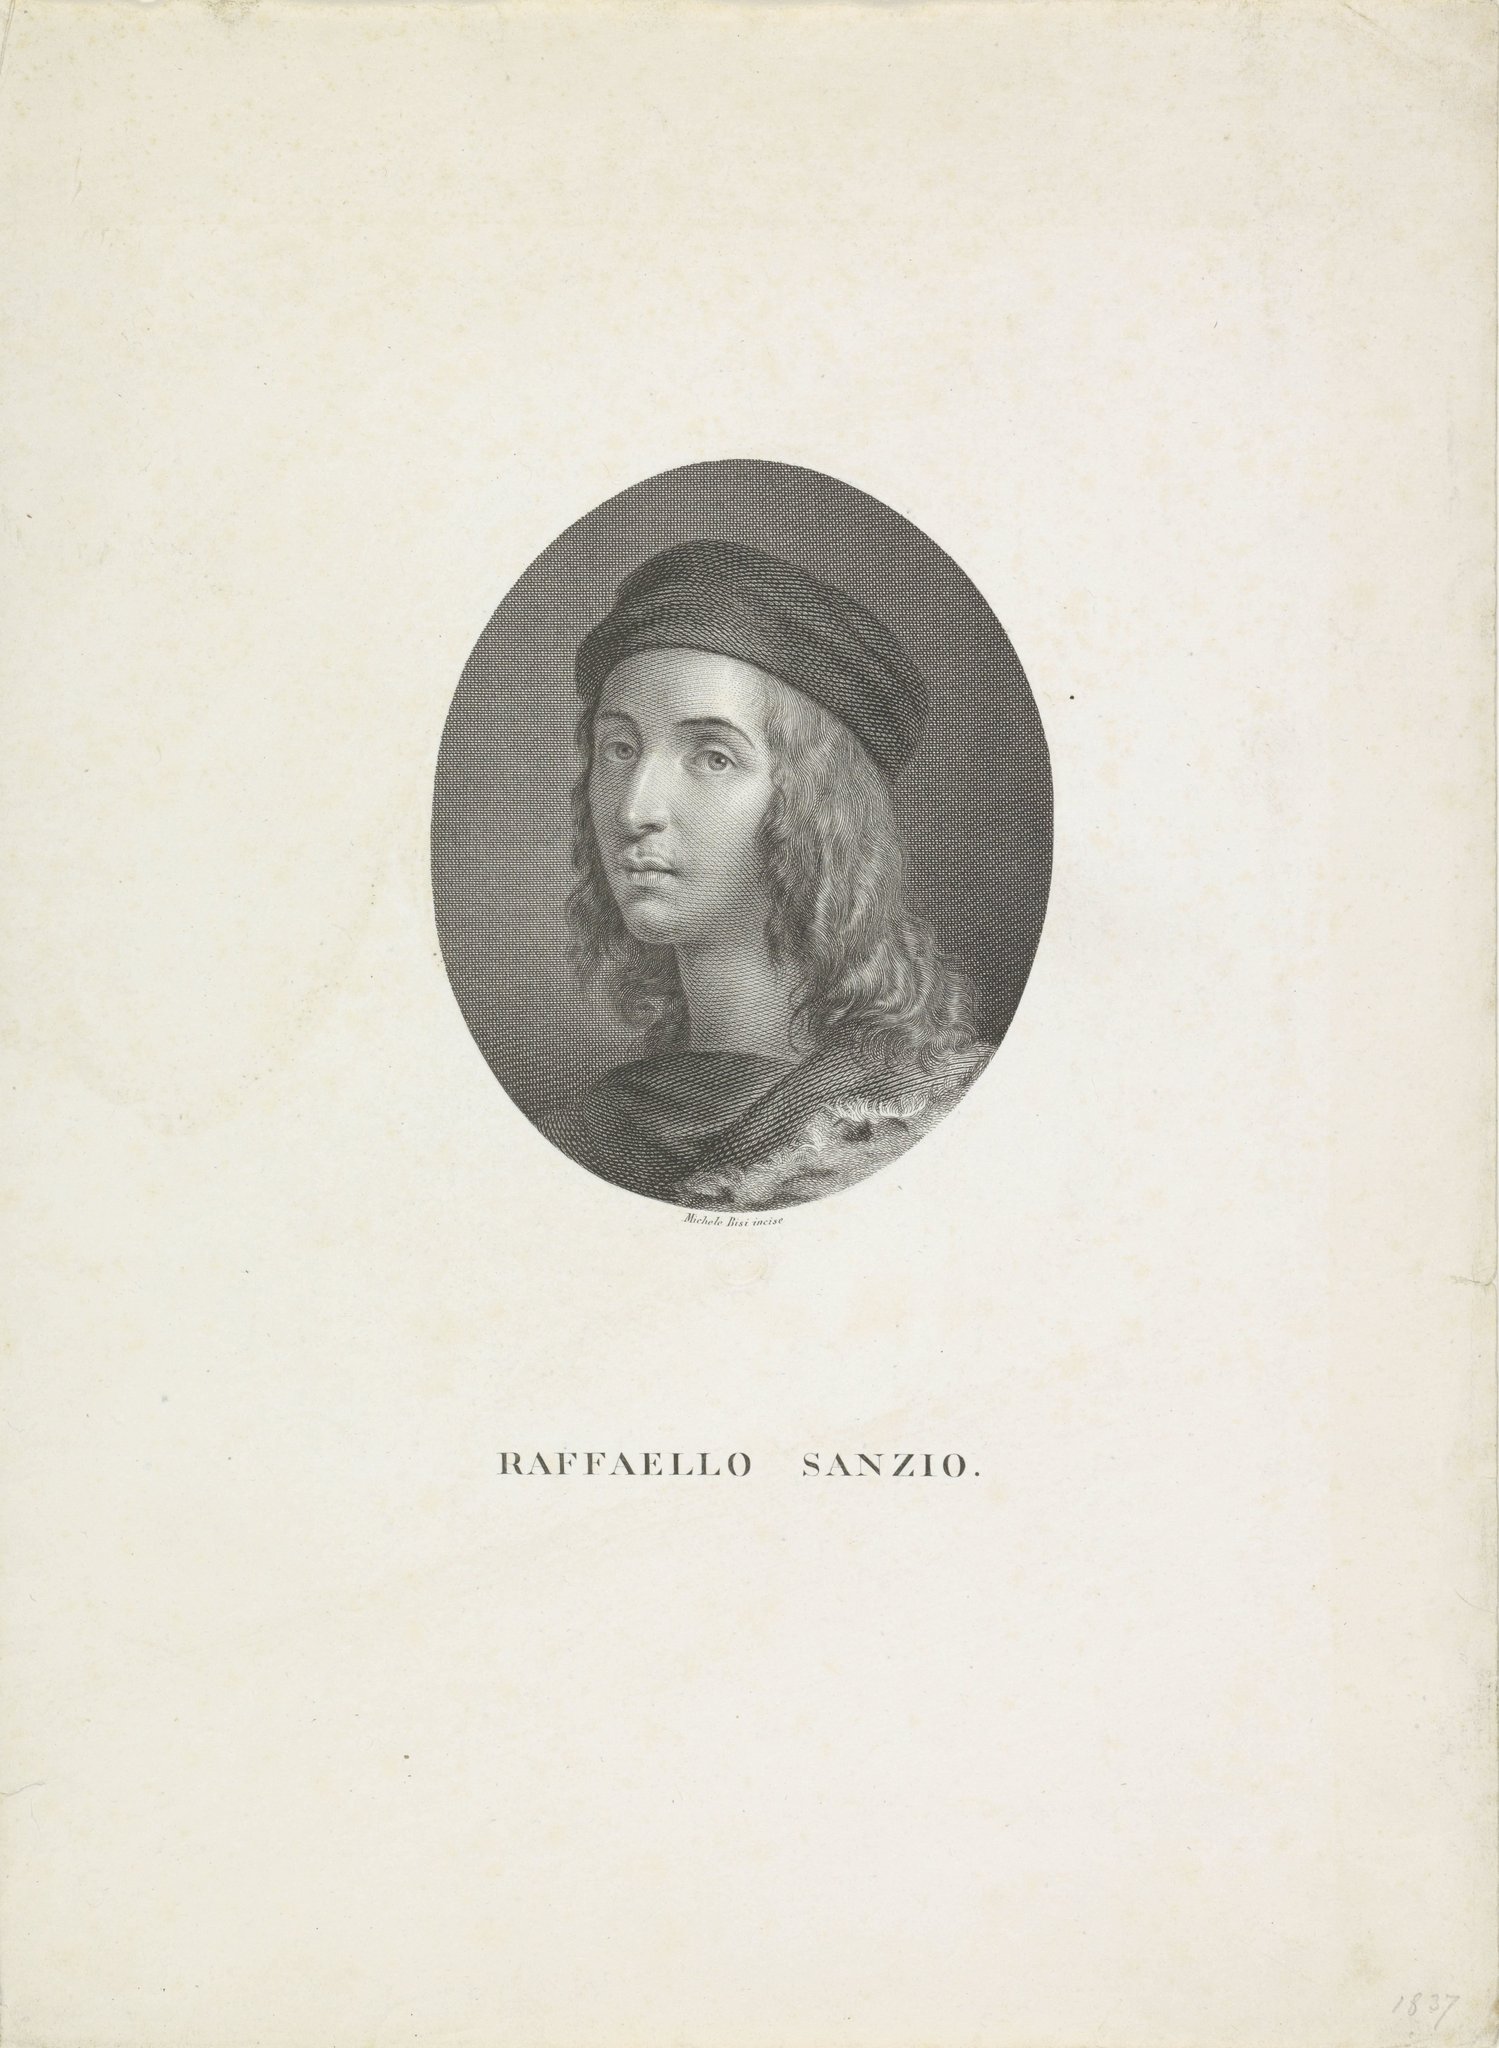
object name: print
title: Portret van Rafaël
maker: michele bisi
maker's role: draughtsman, print maker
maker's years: 1788-1874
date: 1798-1874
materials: paper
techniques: engraving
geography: italy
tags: rome, painter, rafaël, portrait, self-portrait of artist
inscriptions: collector's mark: Lugt 4187, collector's mark: Lugt 2228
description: Deze prent maakt deel uit van een reeks portretprenten van onbekende omvang. De reeks is in meerdere staten uitgegeven. De eerste staat met enkel het portret in ovaal. Een tweede staat met naam van de geportretteerde in holle letters onder de voorstelling. Een derde staat met de naam van de geportretteerde in gevulde letters onder de voorstelling. En een vierde staat met een rechthoekig kader rondom het ovale portret.